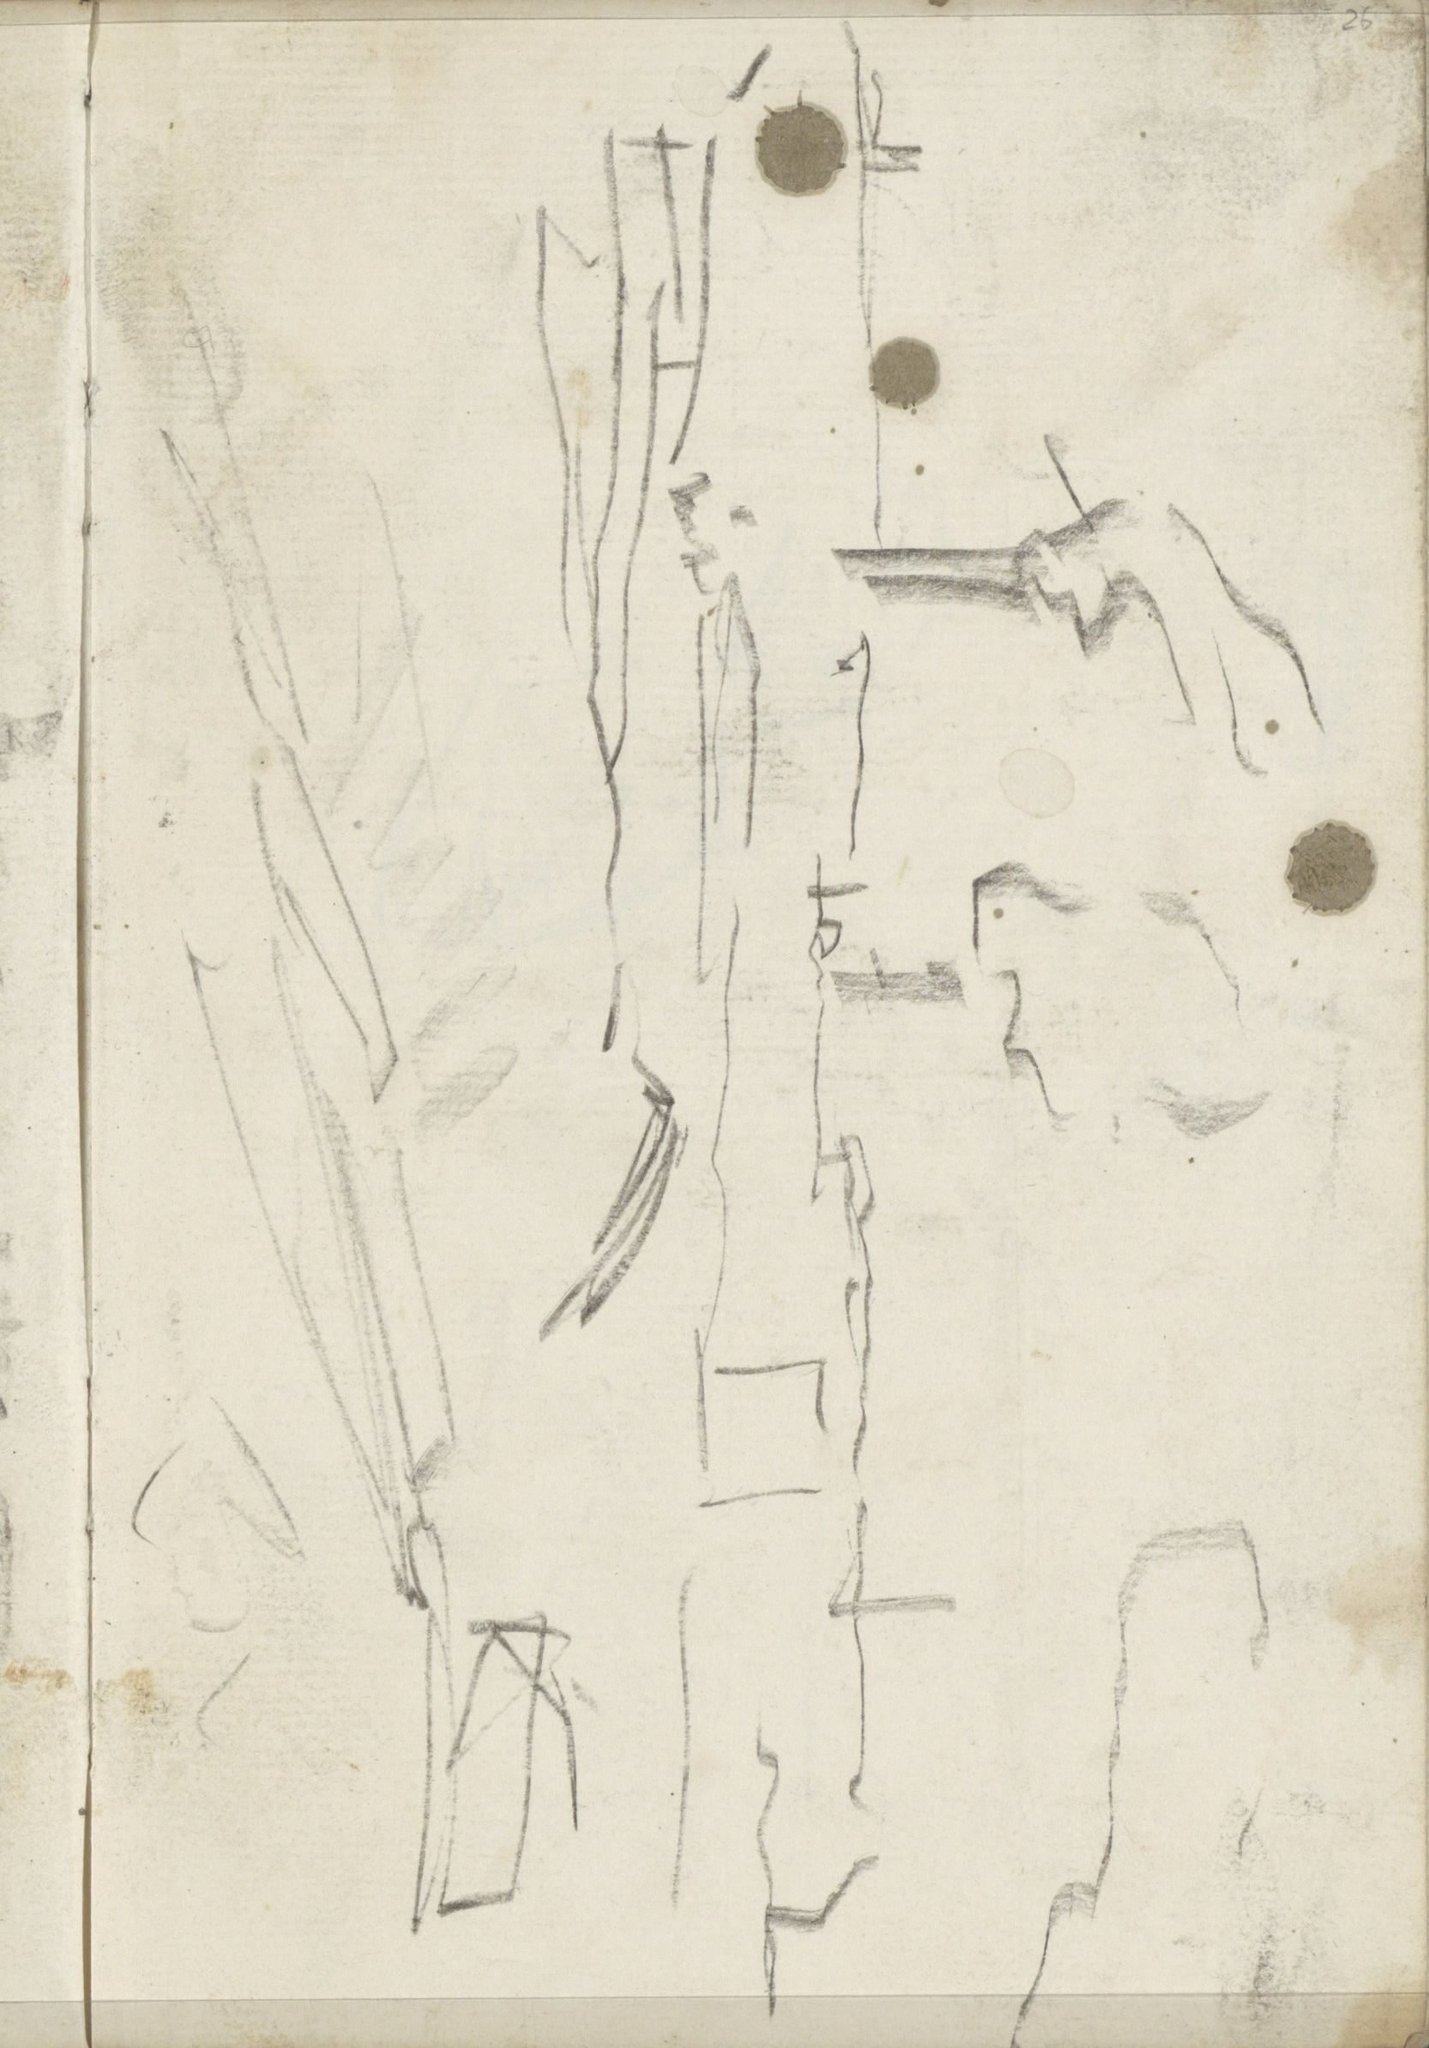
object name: sketchbook leaf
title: Gezicht in Amsterdam met rokende schoorstenen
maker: george hendrik breitner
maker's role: draughtsman, painter, print maker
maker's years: 1857-1923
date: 1886-1898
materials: chalk, paper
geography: amsterdam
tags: city-view, and landscape with man-made constructions, smoke-stack, amsterdam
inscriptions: kleurnotitie, handgeschreven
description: Pagina 26 uit een schetsboek met 21 bladen.